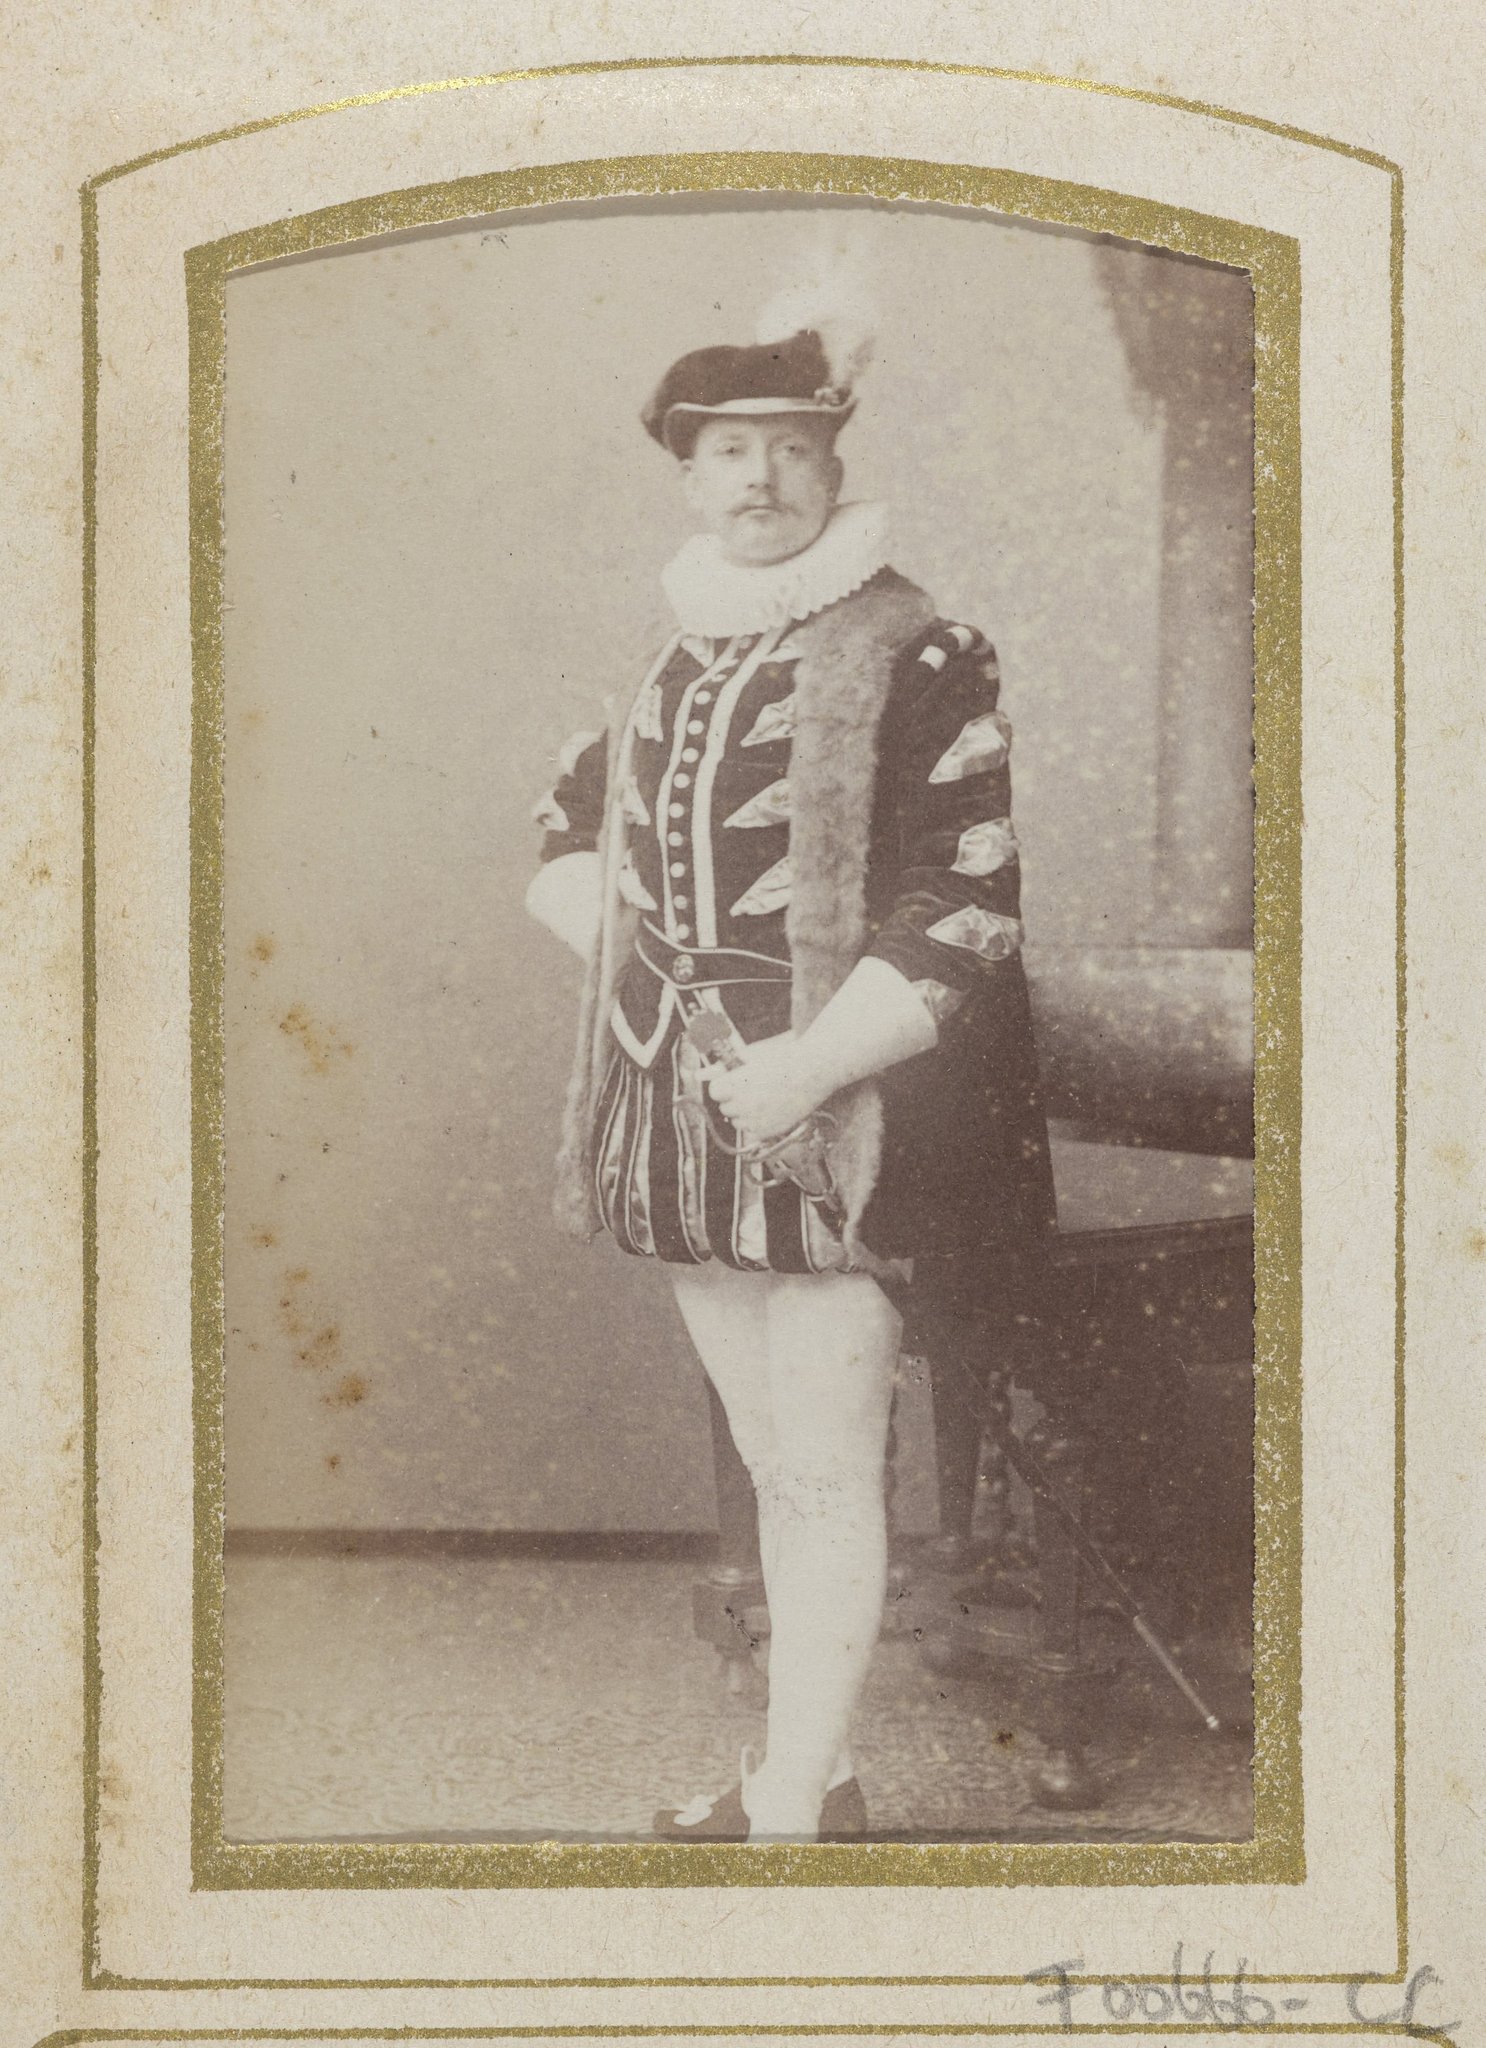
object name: album leaf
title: Portret van een jonge man in kostuum met degen, aangeduid als G.J. Nijhuis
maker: jan goedeljee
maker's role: fotograaf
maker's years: 1824-1905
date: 1860-1905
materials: cardboard, photographic support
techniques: albumen print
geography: leiden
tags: historical persons, historical costume, hacking and thrusting weapons: rapier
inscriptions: inscription: ‘J. Goedeljee/ Photograaf/ Z. K. H. PRINS ALEXANDER/ der Nederlanden/ PRINS van ORANJE/ en H. K. H./ PRINSES HENDRIK/ der Nederlanden/ Hoogewoerd 160/ nabij de Plantage.’, name: ‘G. J. Nijhuis./ 121.’